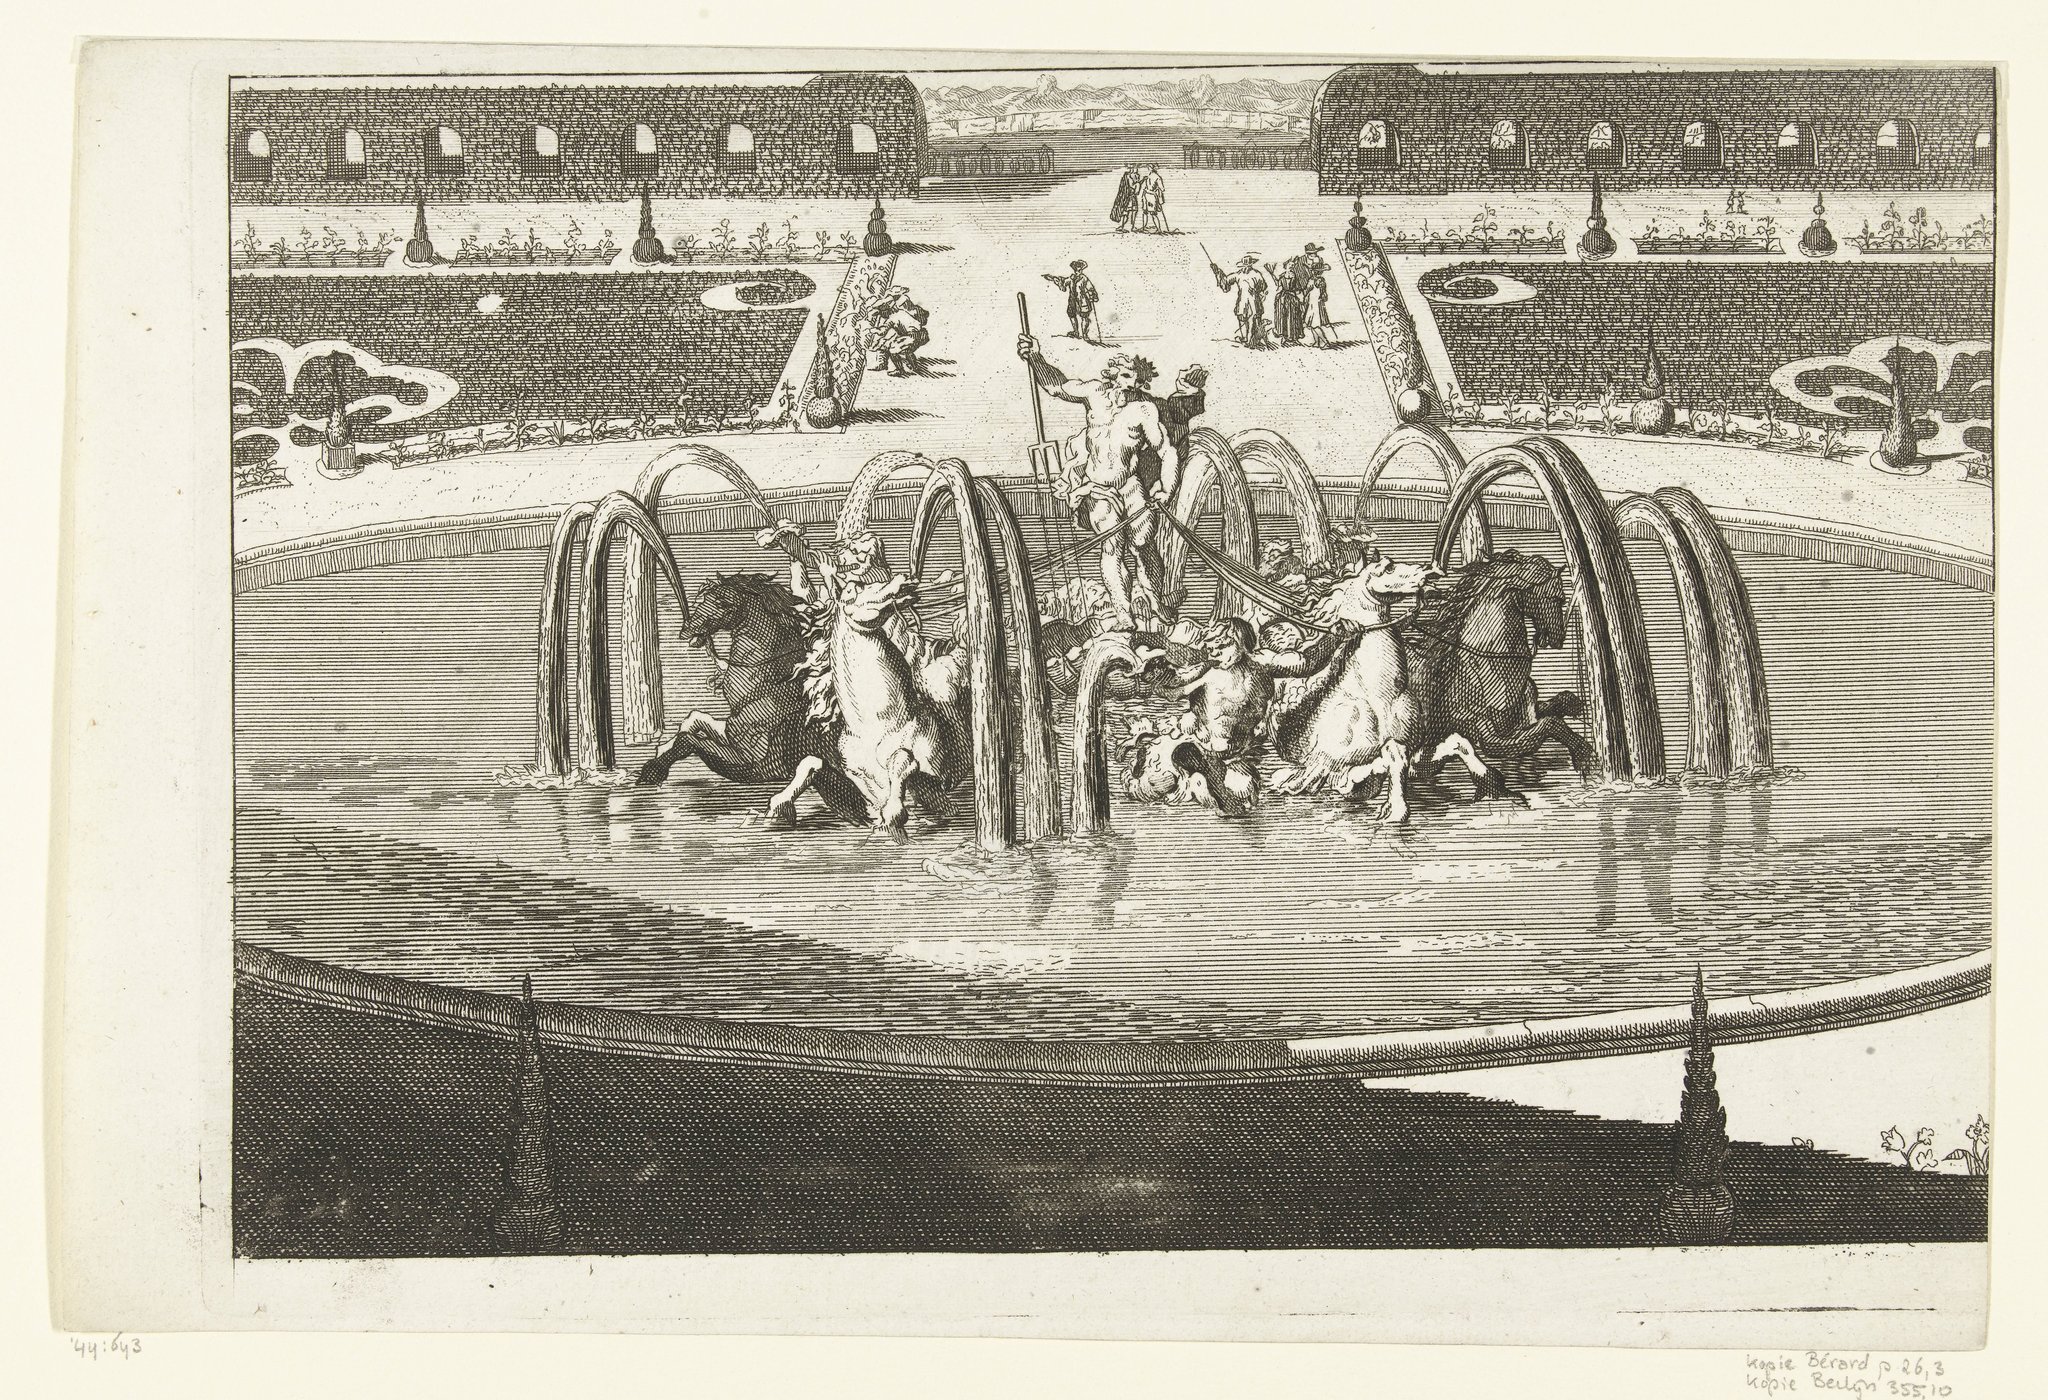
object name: print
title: Nova Fontium Delineatio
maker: Anonymous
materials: paper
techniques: etching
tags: garden fountain, triumph of neptune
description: De wagen wordt getrokken door vier zeepaarden. Kopie naar blad uit serie Liure de fontaines uitgegeven door Daniel Marot.